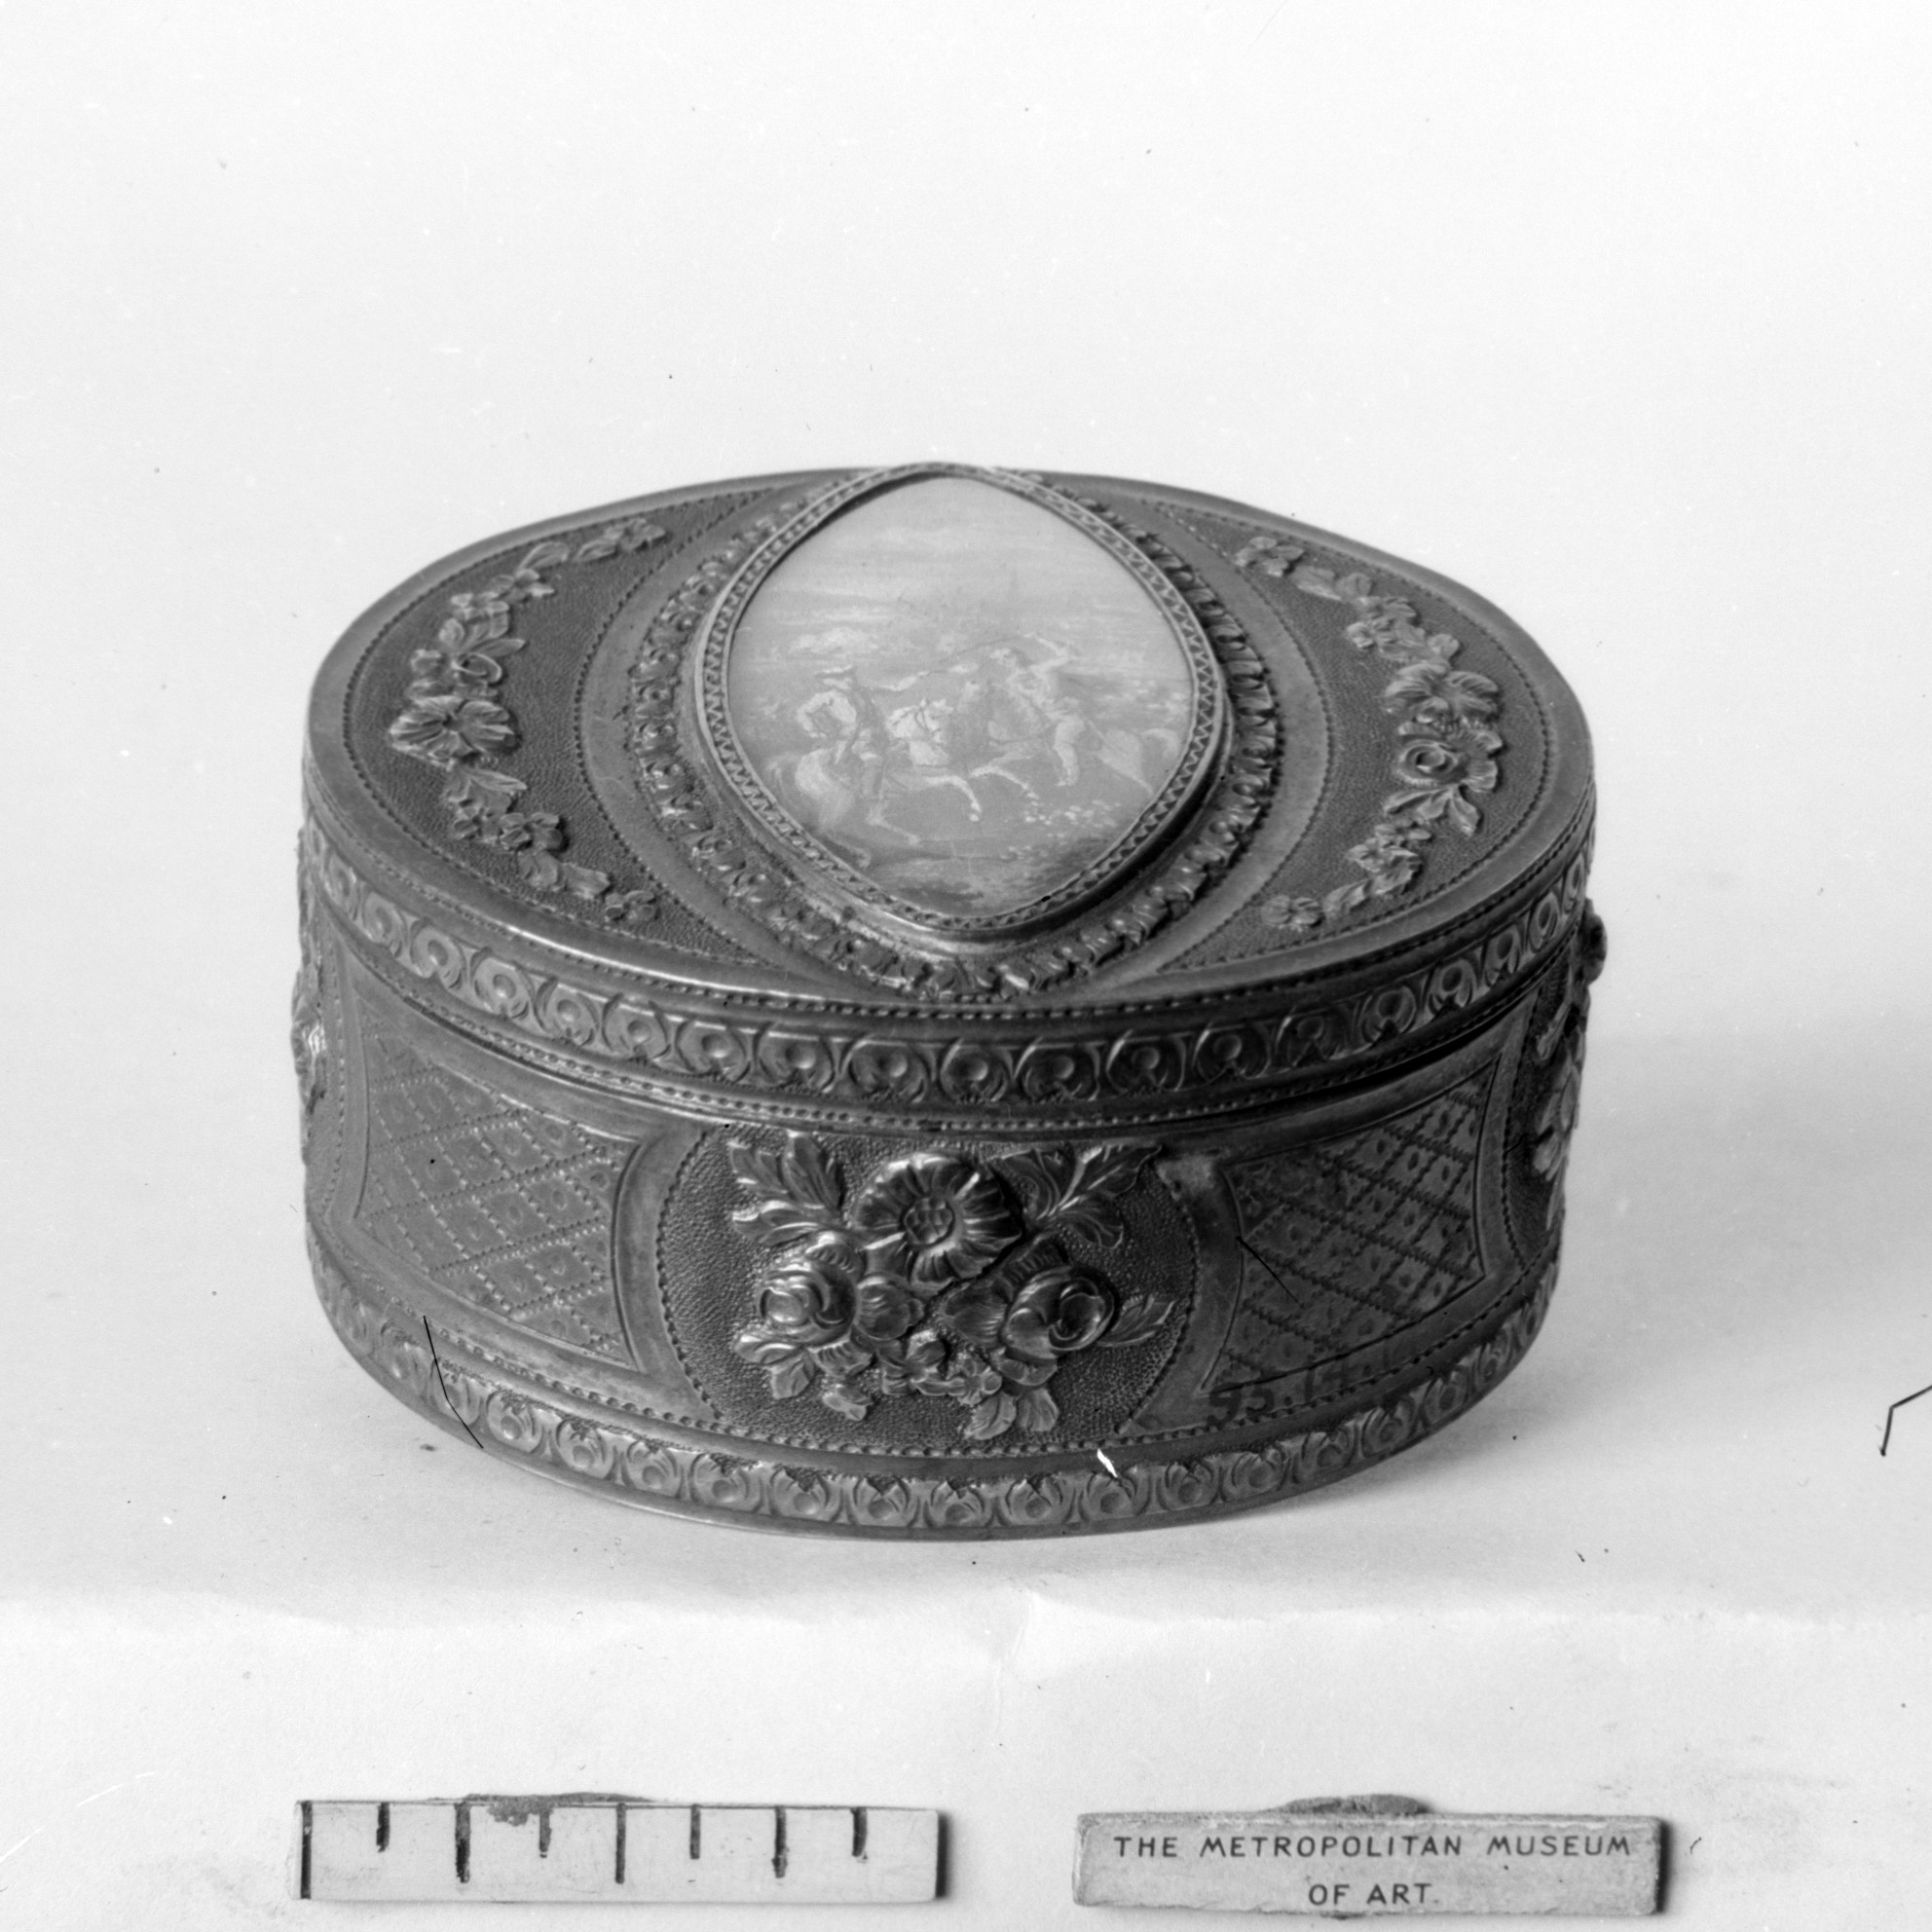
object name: snuffbox, painting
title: Snuffbox with miniature representing battle scene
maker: louis nicolas van blarenberghe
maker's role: artist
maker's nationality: french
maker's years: 1716-1794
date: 1767-1800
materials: gold, silver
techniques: painting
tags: battles,horses,flowers